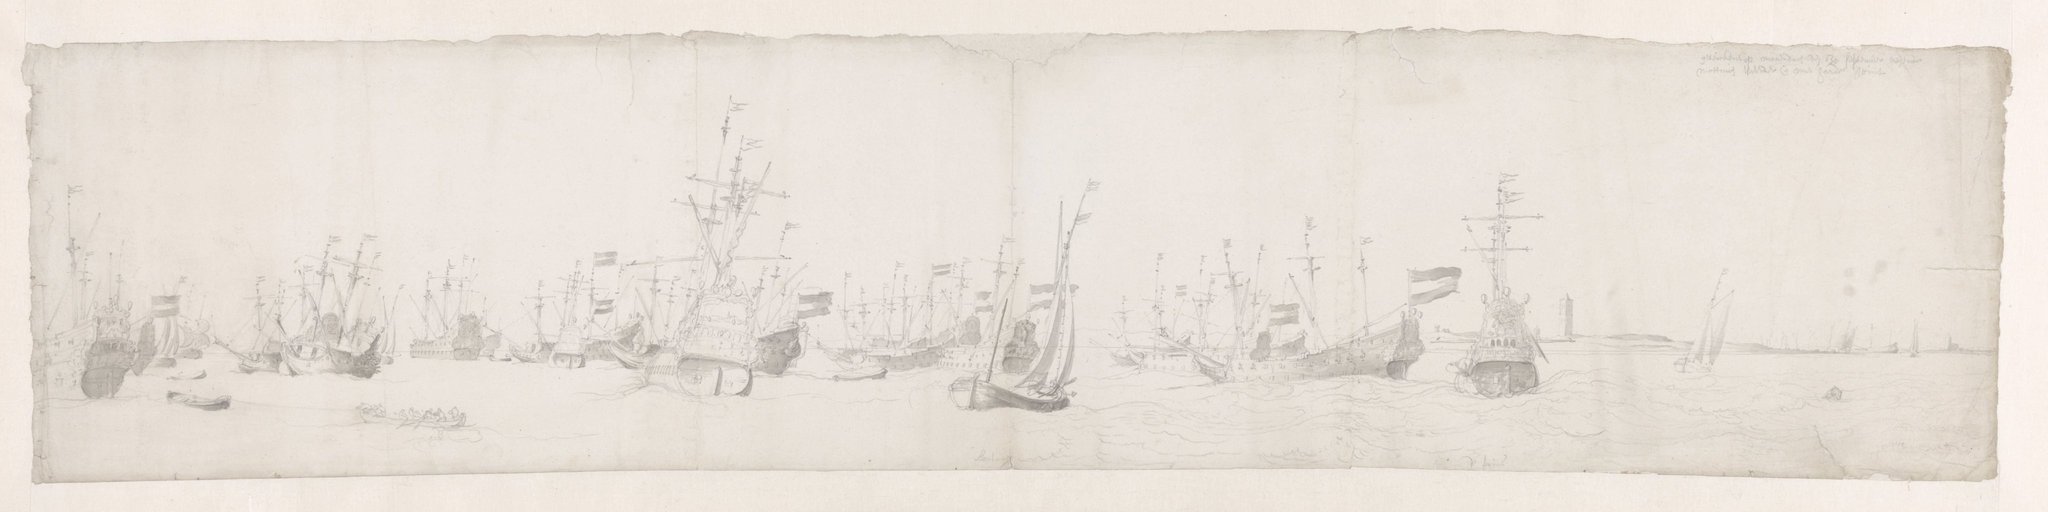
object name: drawing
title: Het eskader van Van Wassenaer Obdam met zijn vlag op de Eendracht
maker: willem van de velde (ii)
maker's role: draughtsman, painter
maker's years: 1633-1707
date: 1643-1665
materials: paper, pencil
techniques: brush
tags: sailing-ship, sailing-boat, sea (seascape), navy (+ sailing-ships)